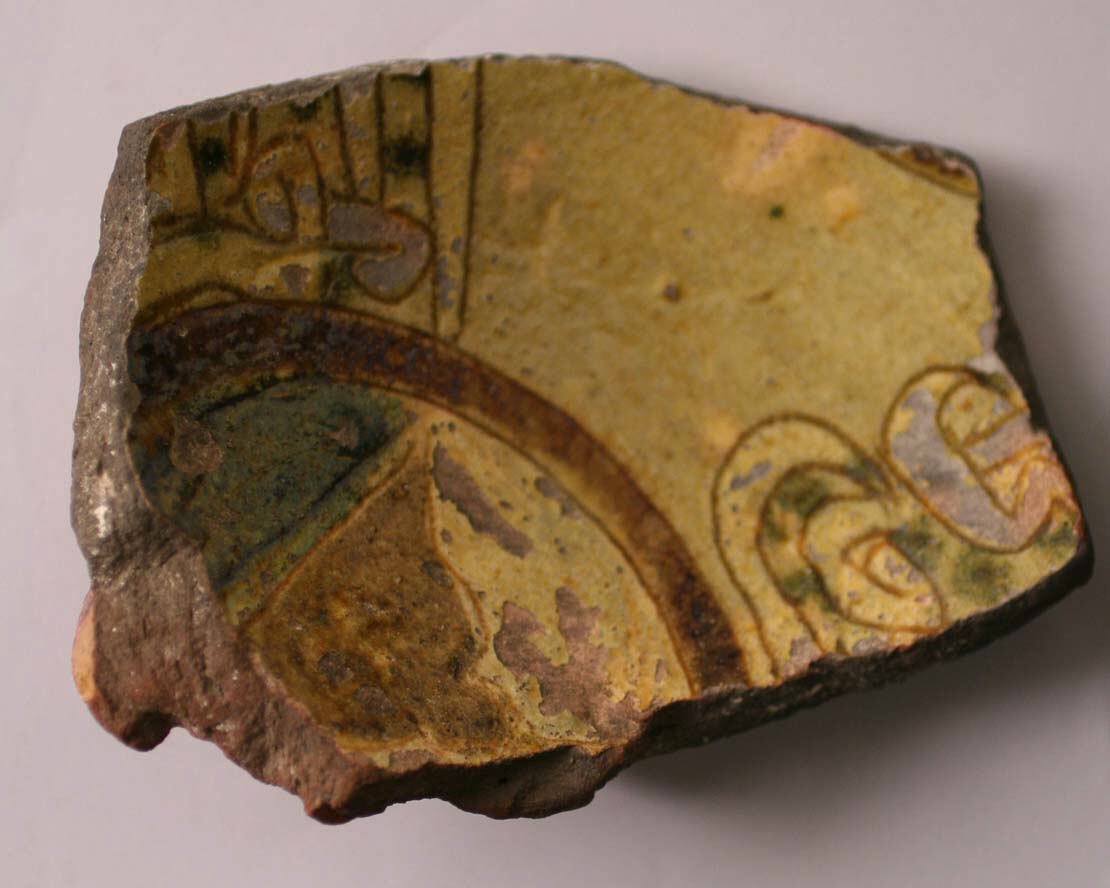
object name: fragment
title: Fragment of a Bowl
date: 1301-1500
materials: earthenware, glaze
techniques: coloring, incising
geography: egypt